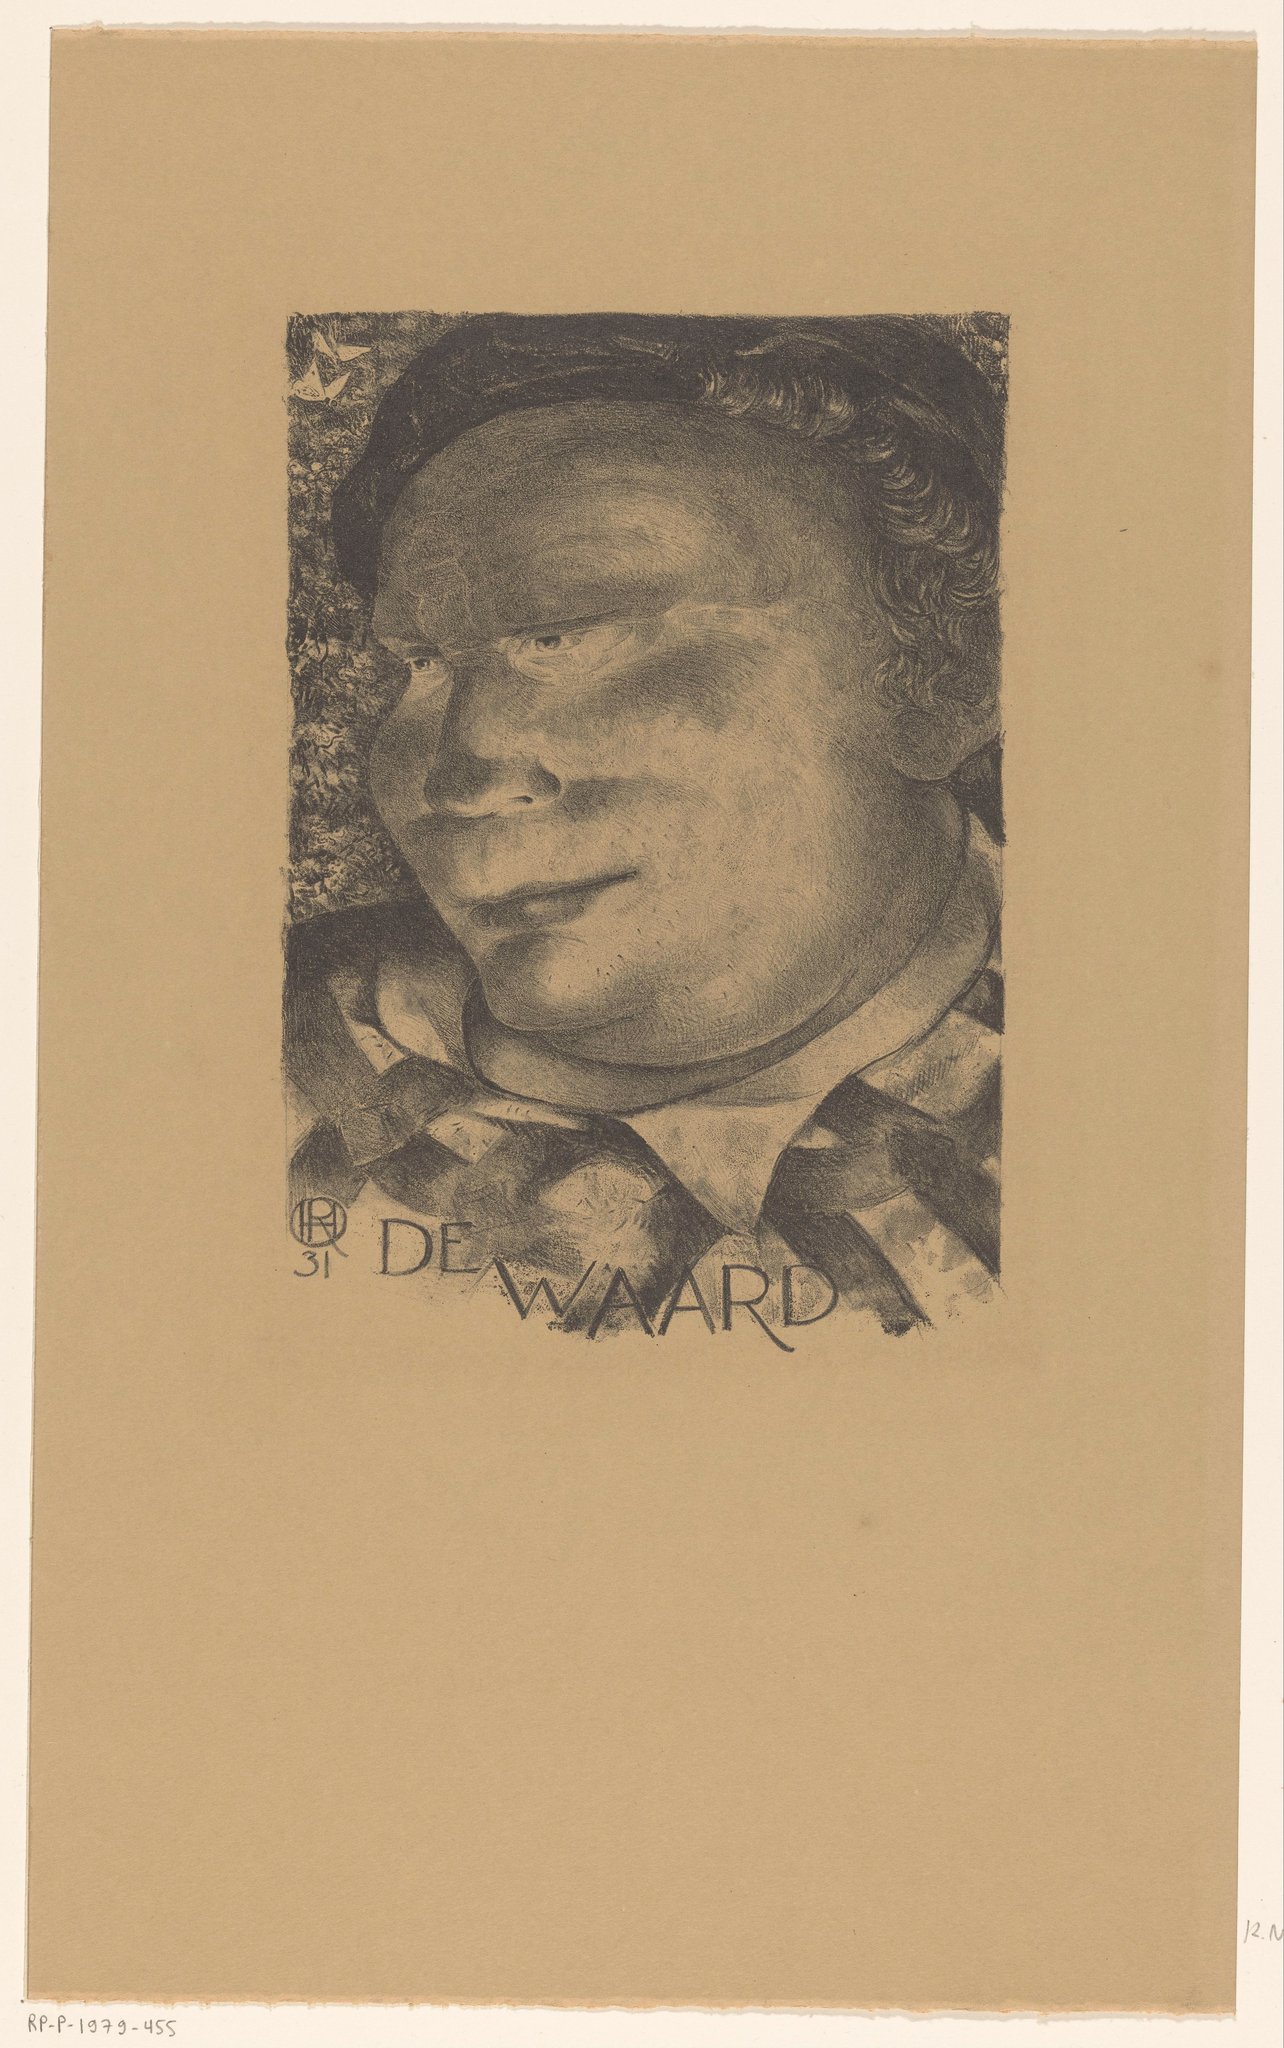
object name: print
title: Brabantse types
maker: richard nicolaüs roland holst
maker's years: 1868-1938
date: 1931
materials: paper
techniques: lithograph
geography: buissche heide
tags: head (human), inn, coffee-house, public house, etc. (+ innkeeper, host)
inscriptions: collector's mark: Lugt 2228